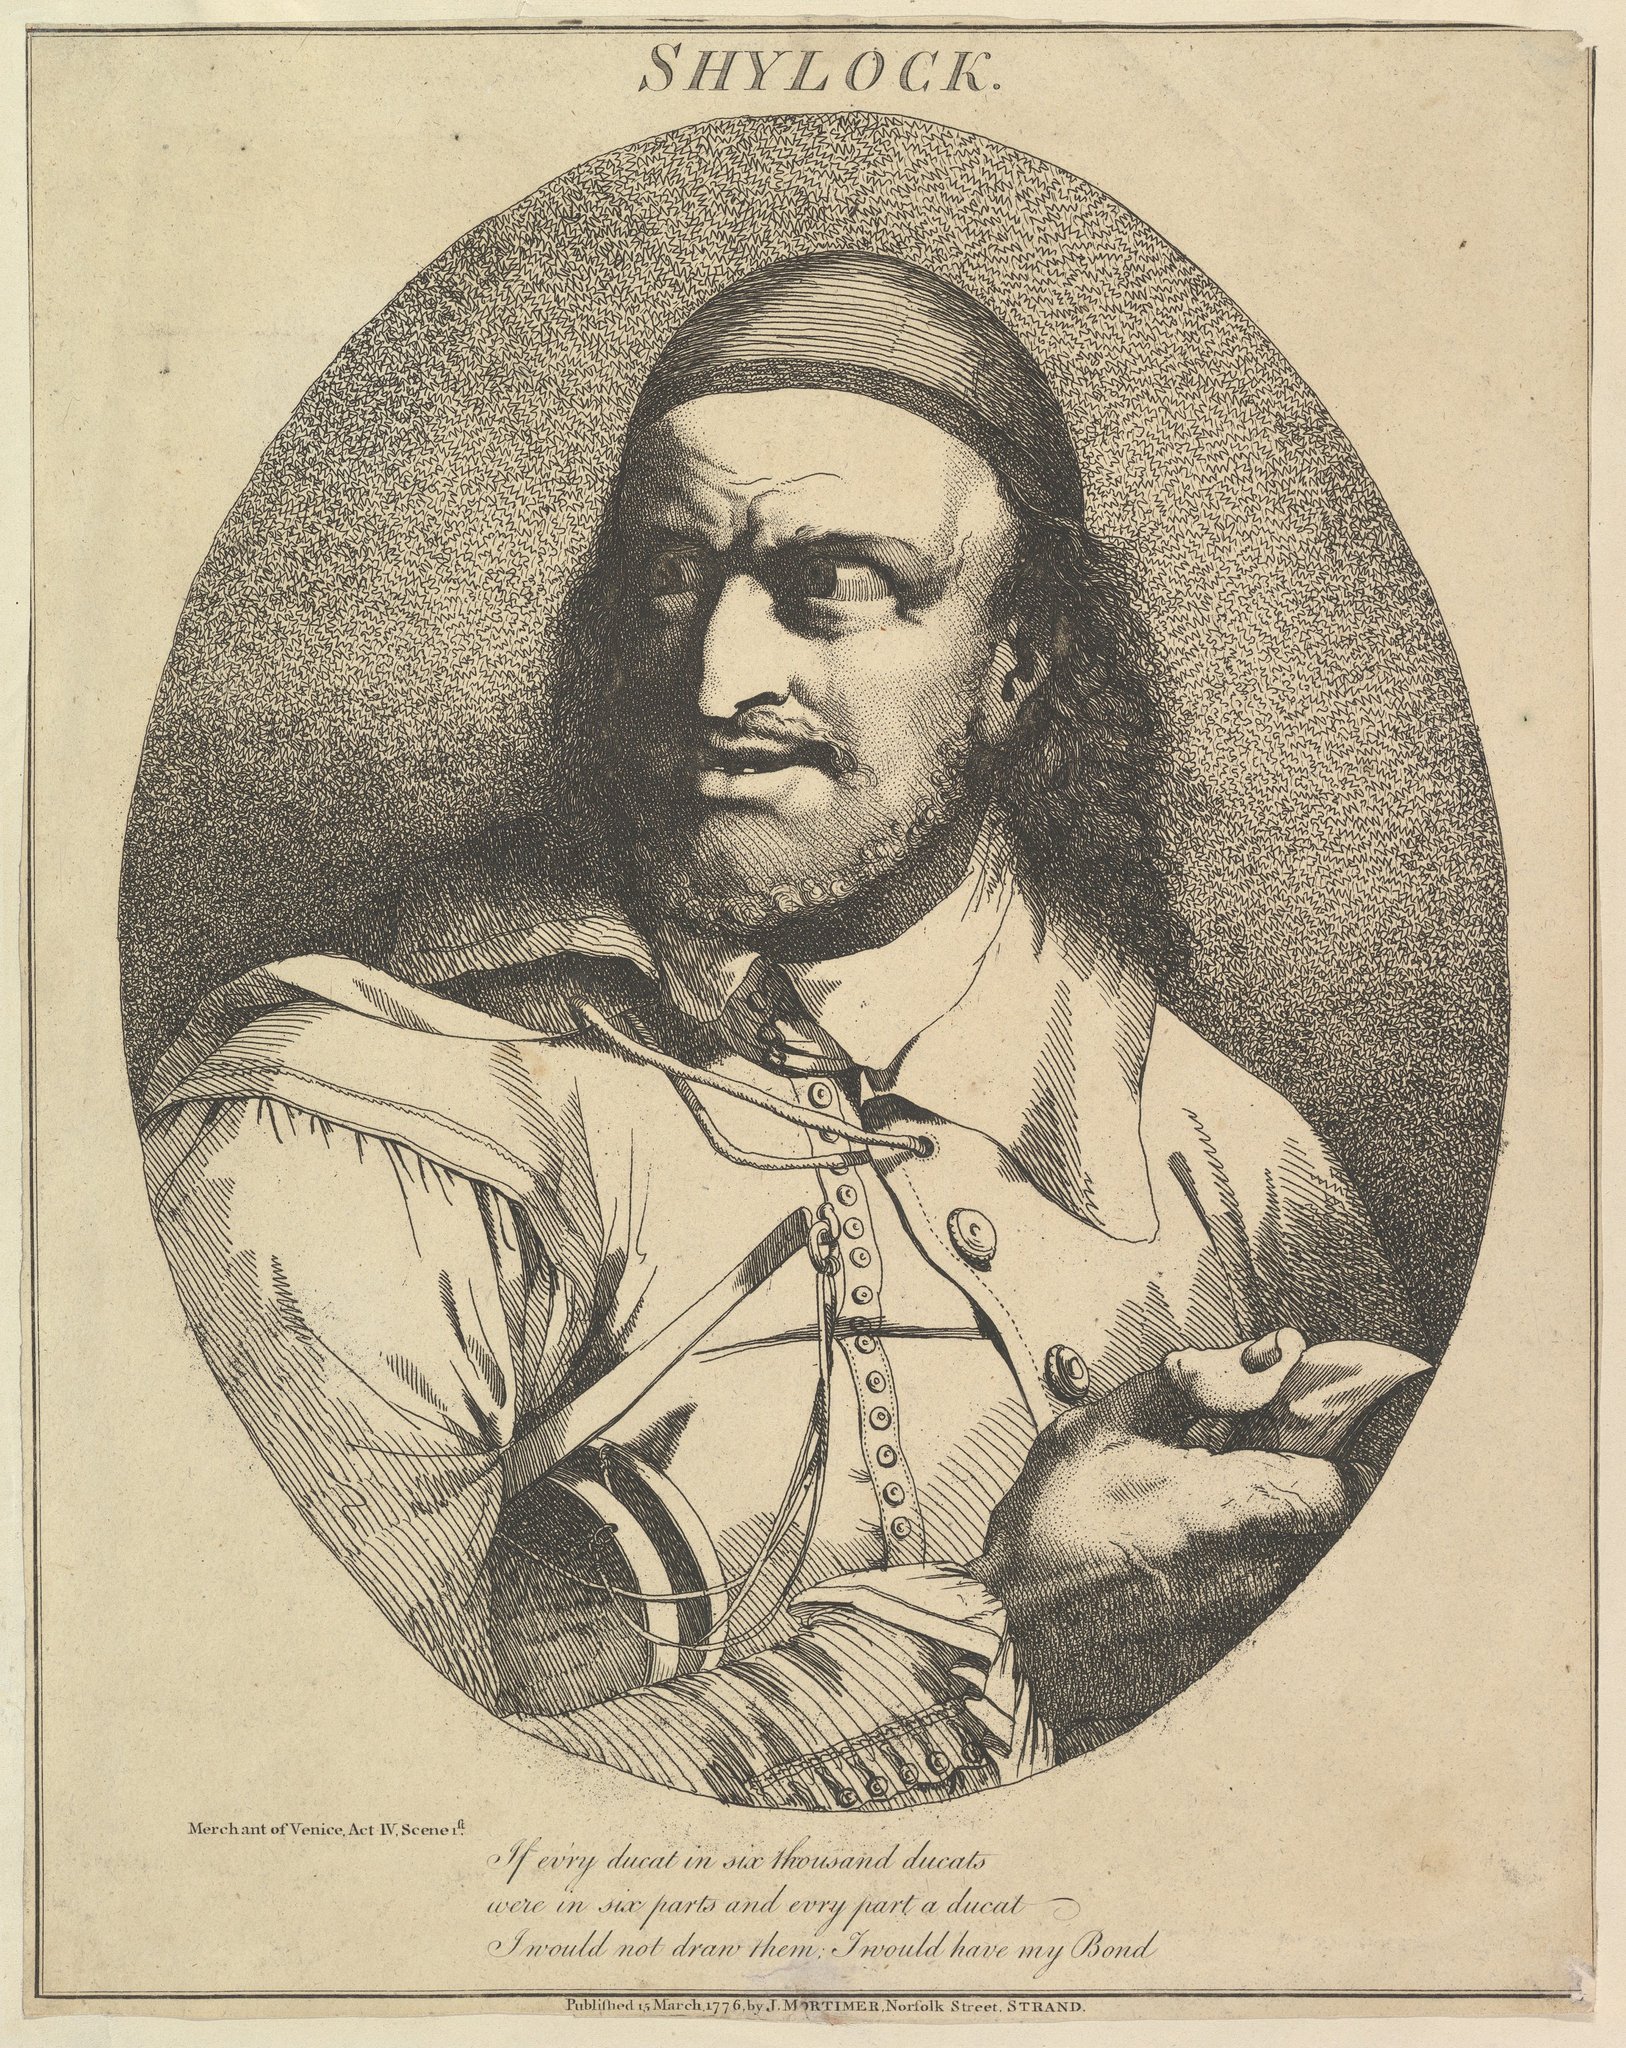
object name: print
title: Shylock, from "Twelve Characters from Shakespeare"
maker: john hamilton mortimer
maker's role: artist and publisher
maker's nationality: british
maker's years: 1740-1779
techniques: etching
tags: shakespeare,men